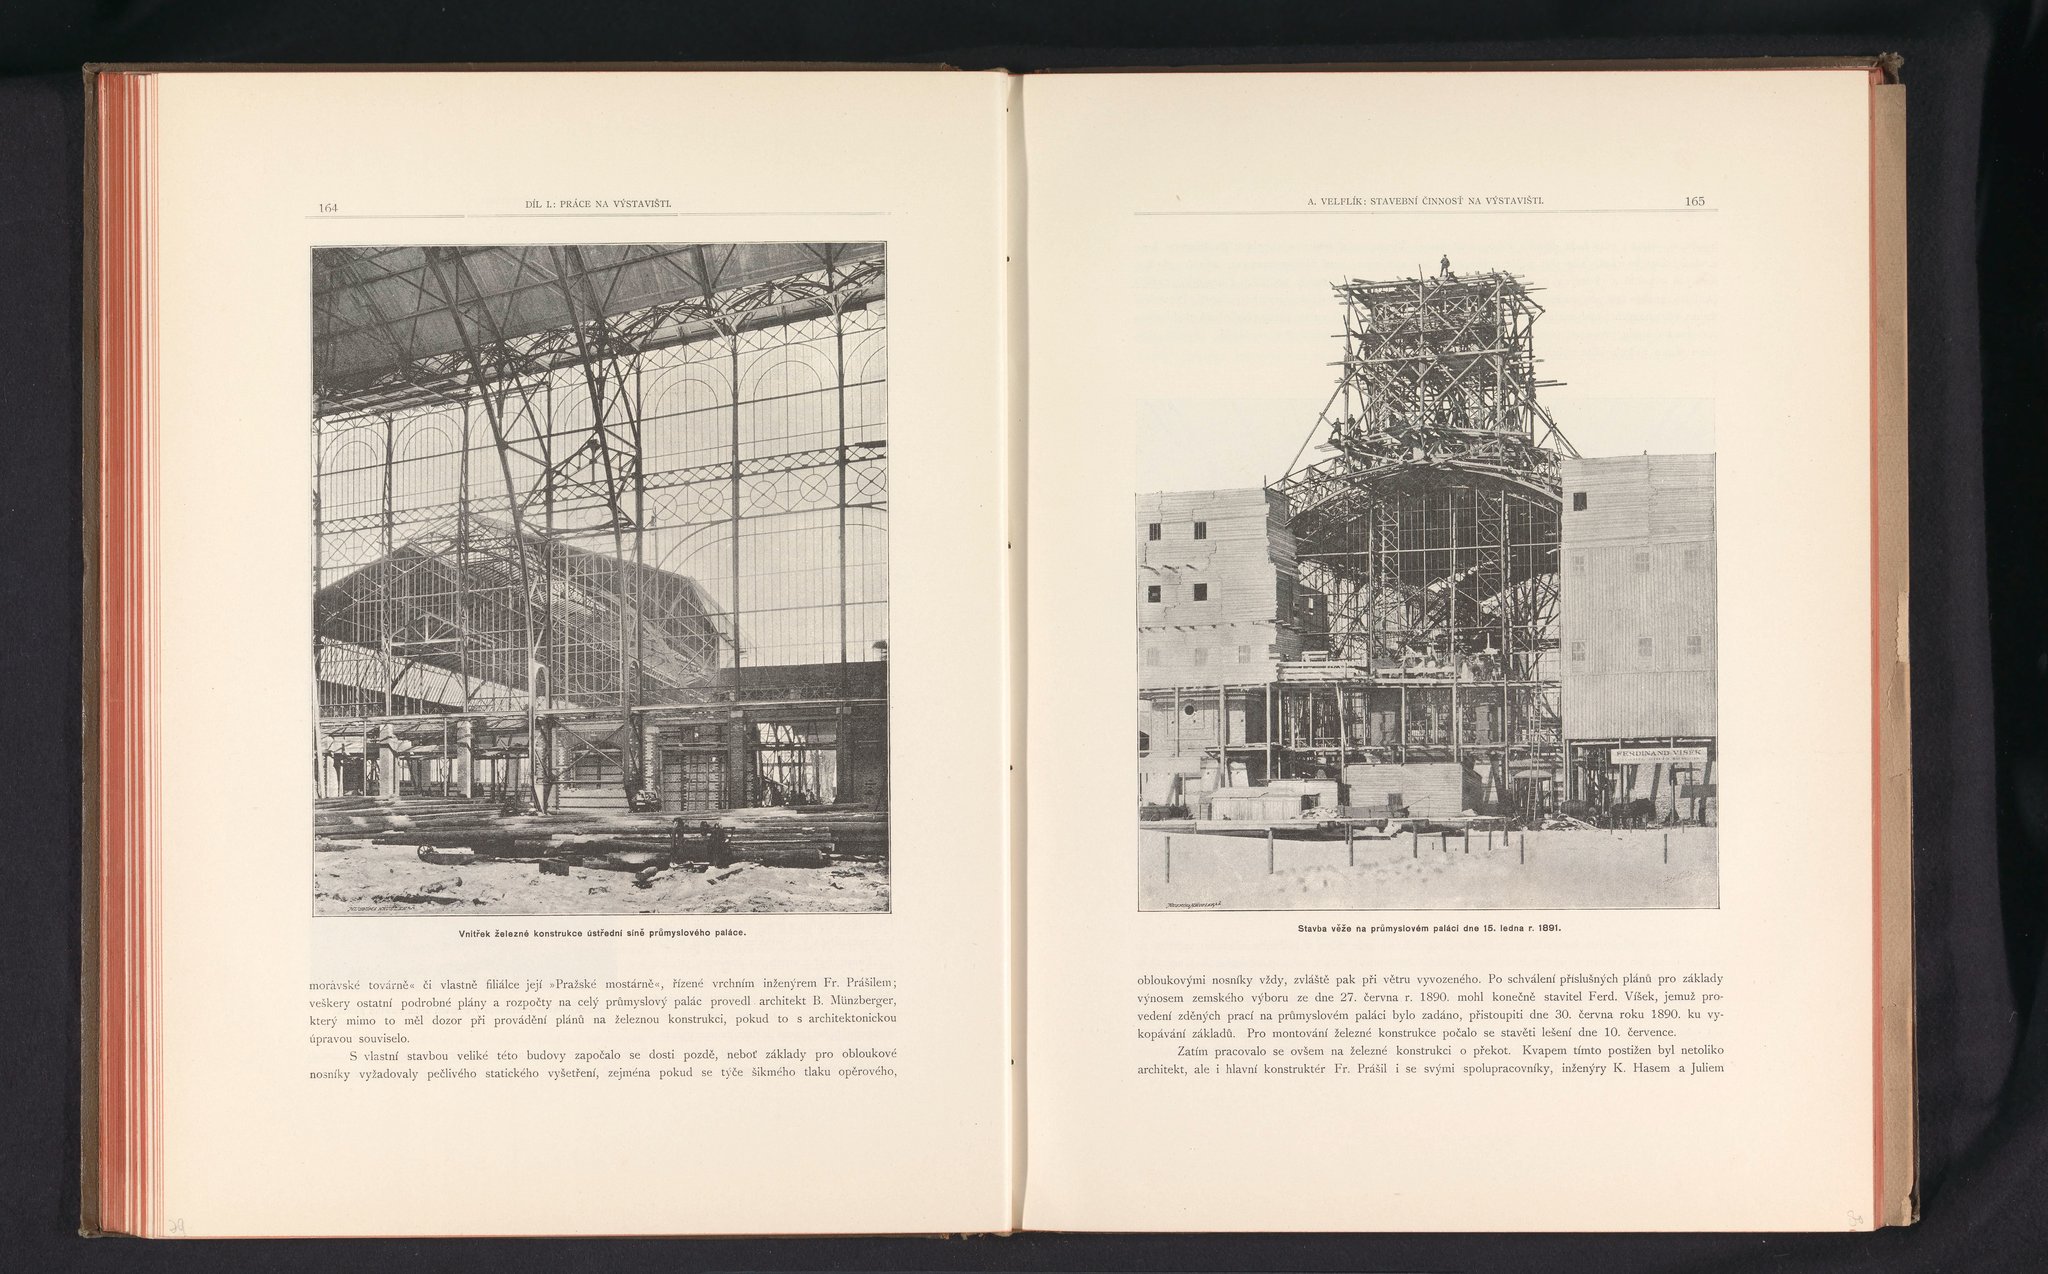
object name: photomechanical print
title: Stavba veze na prumyslovem paláci dne 15. ledna r. 1891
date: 1891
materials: paper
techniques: autotype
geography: výstaviště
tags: building-site